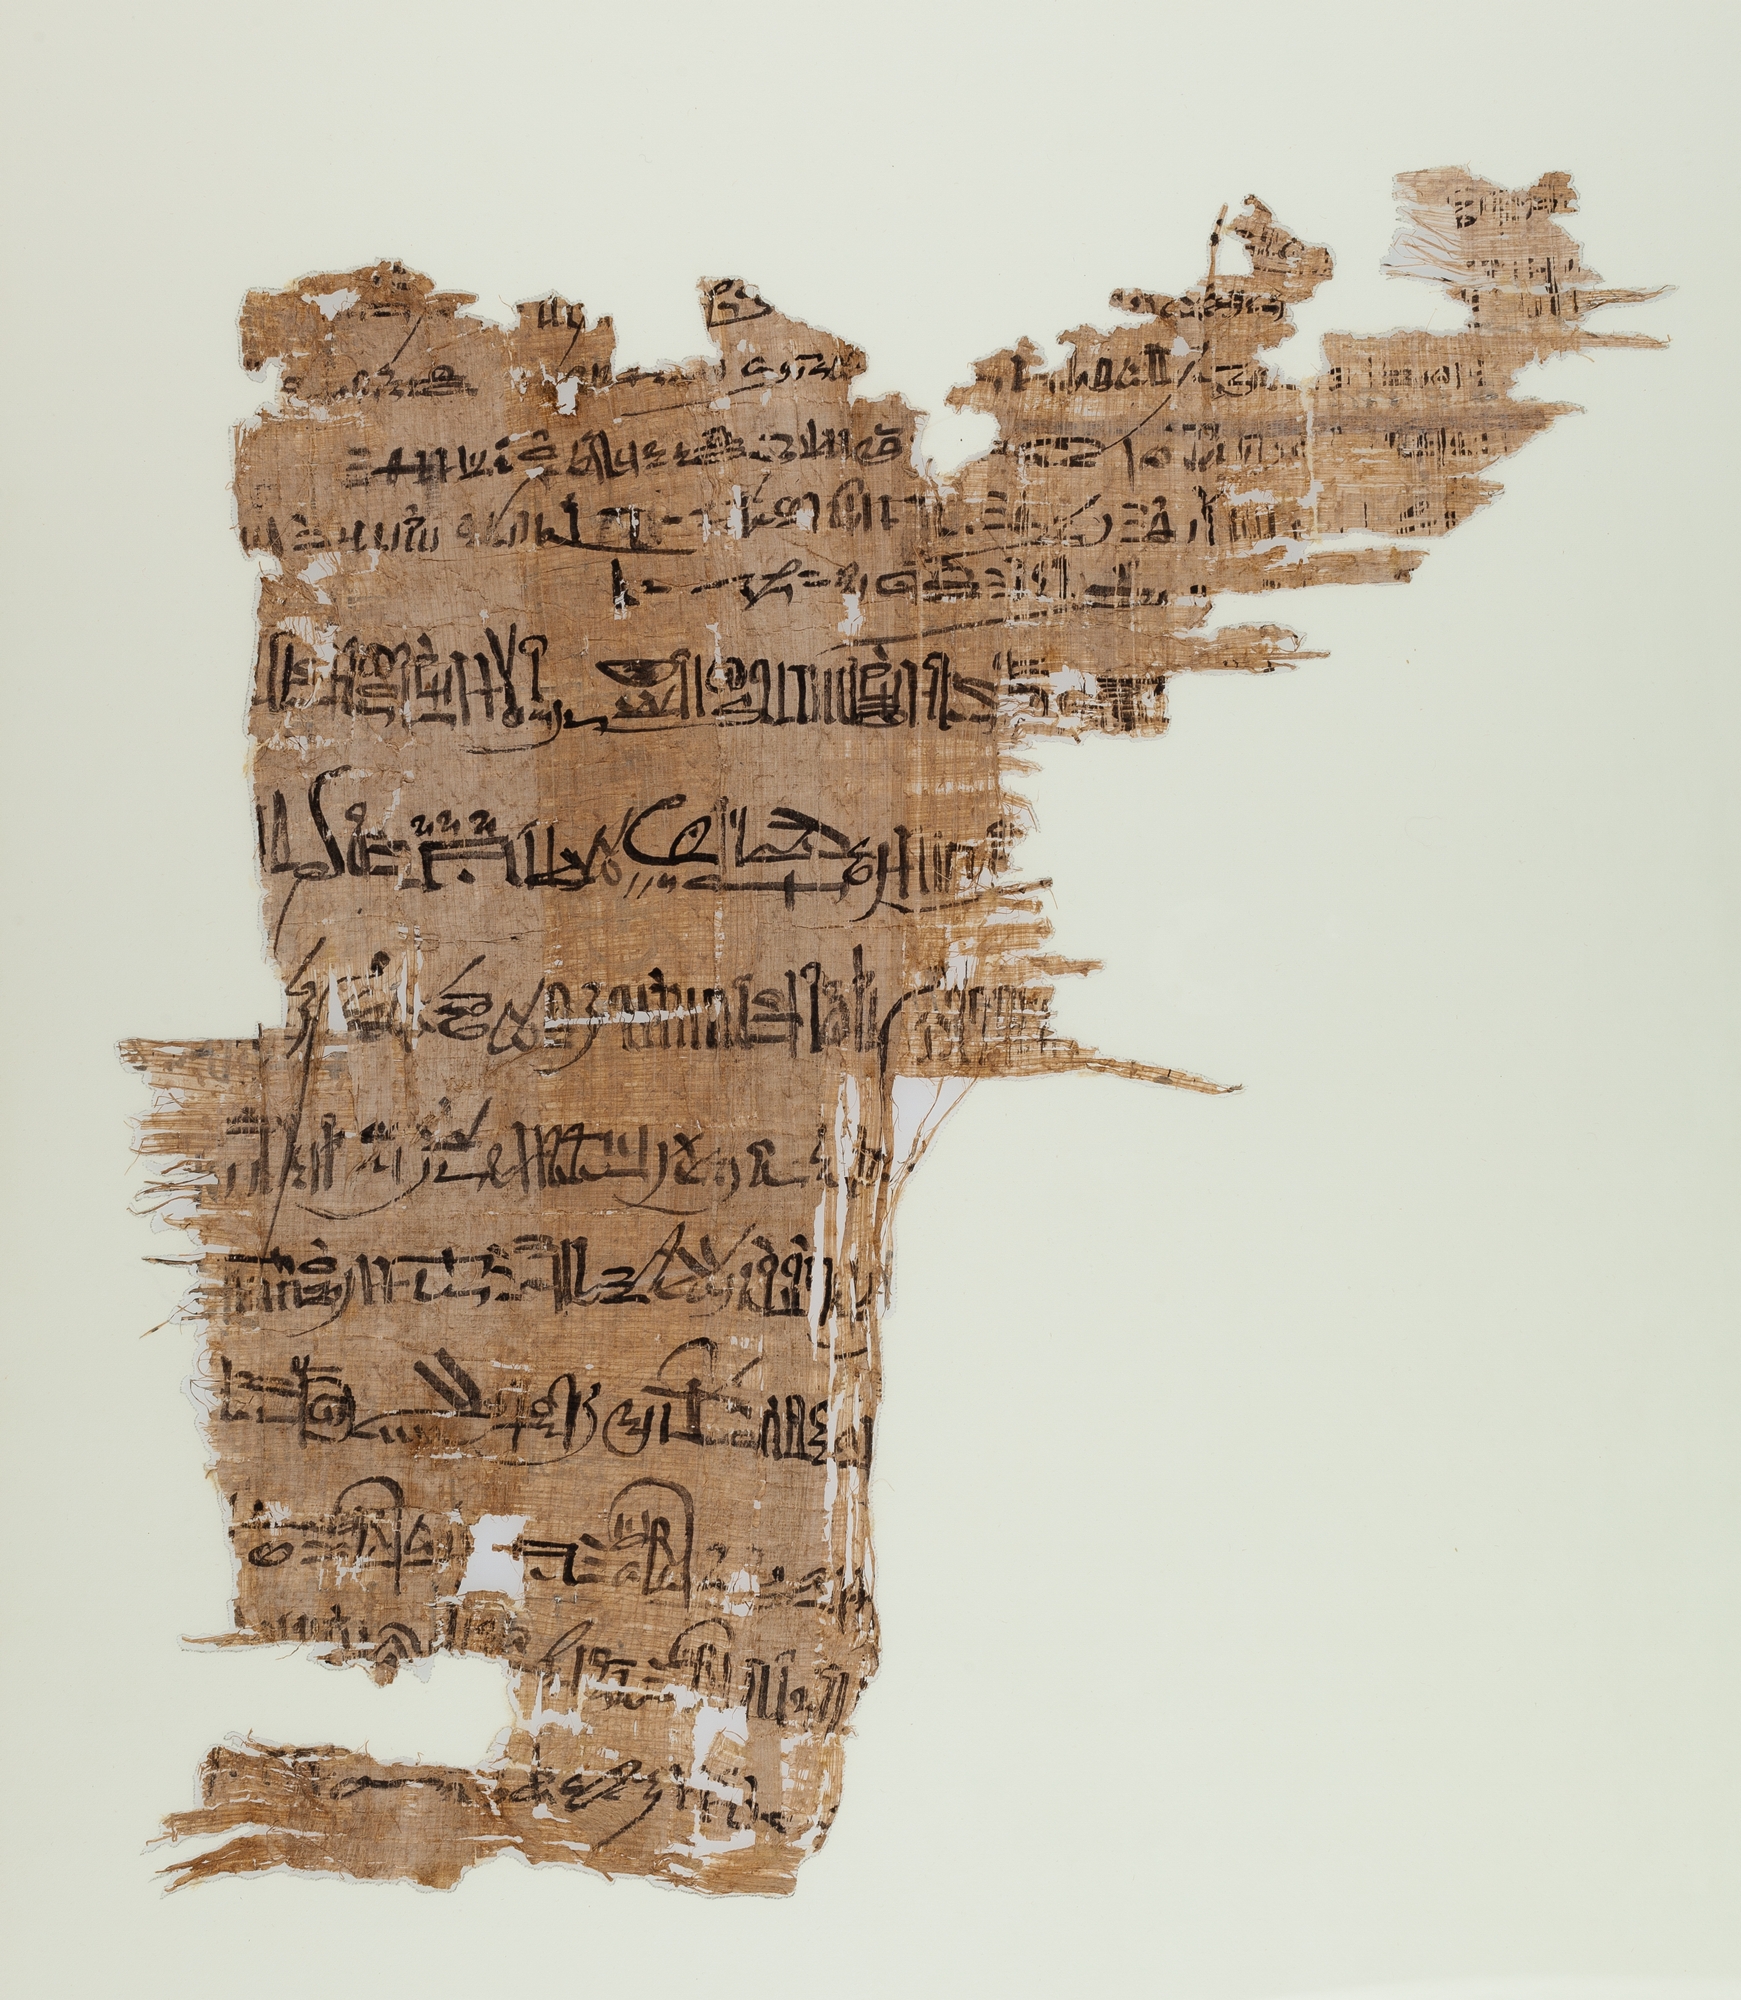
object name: papyrus, letter, account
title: Hieratic Papyrus fragment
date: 1183 BCE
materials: ink, papyrus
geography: memphite region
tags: documents,hieratic